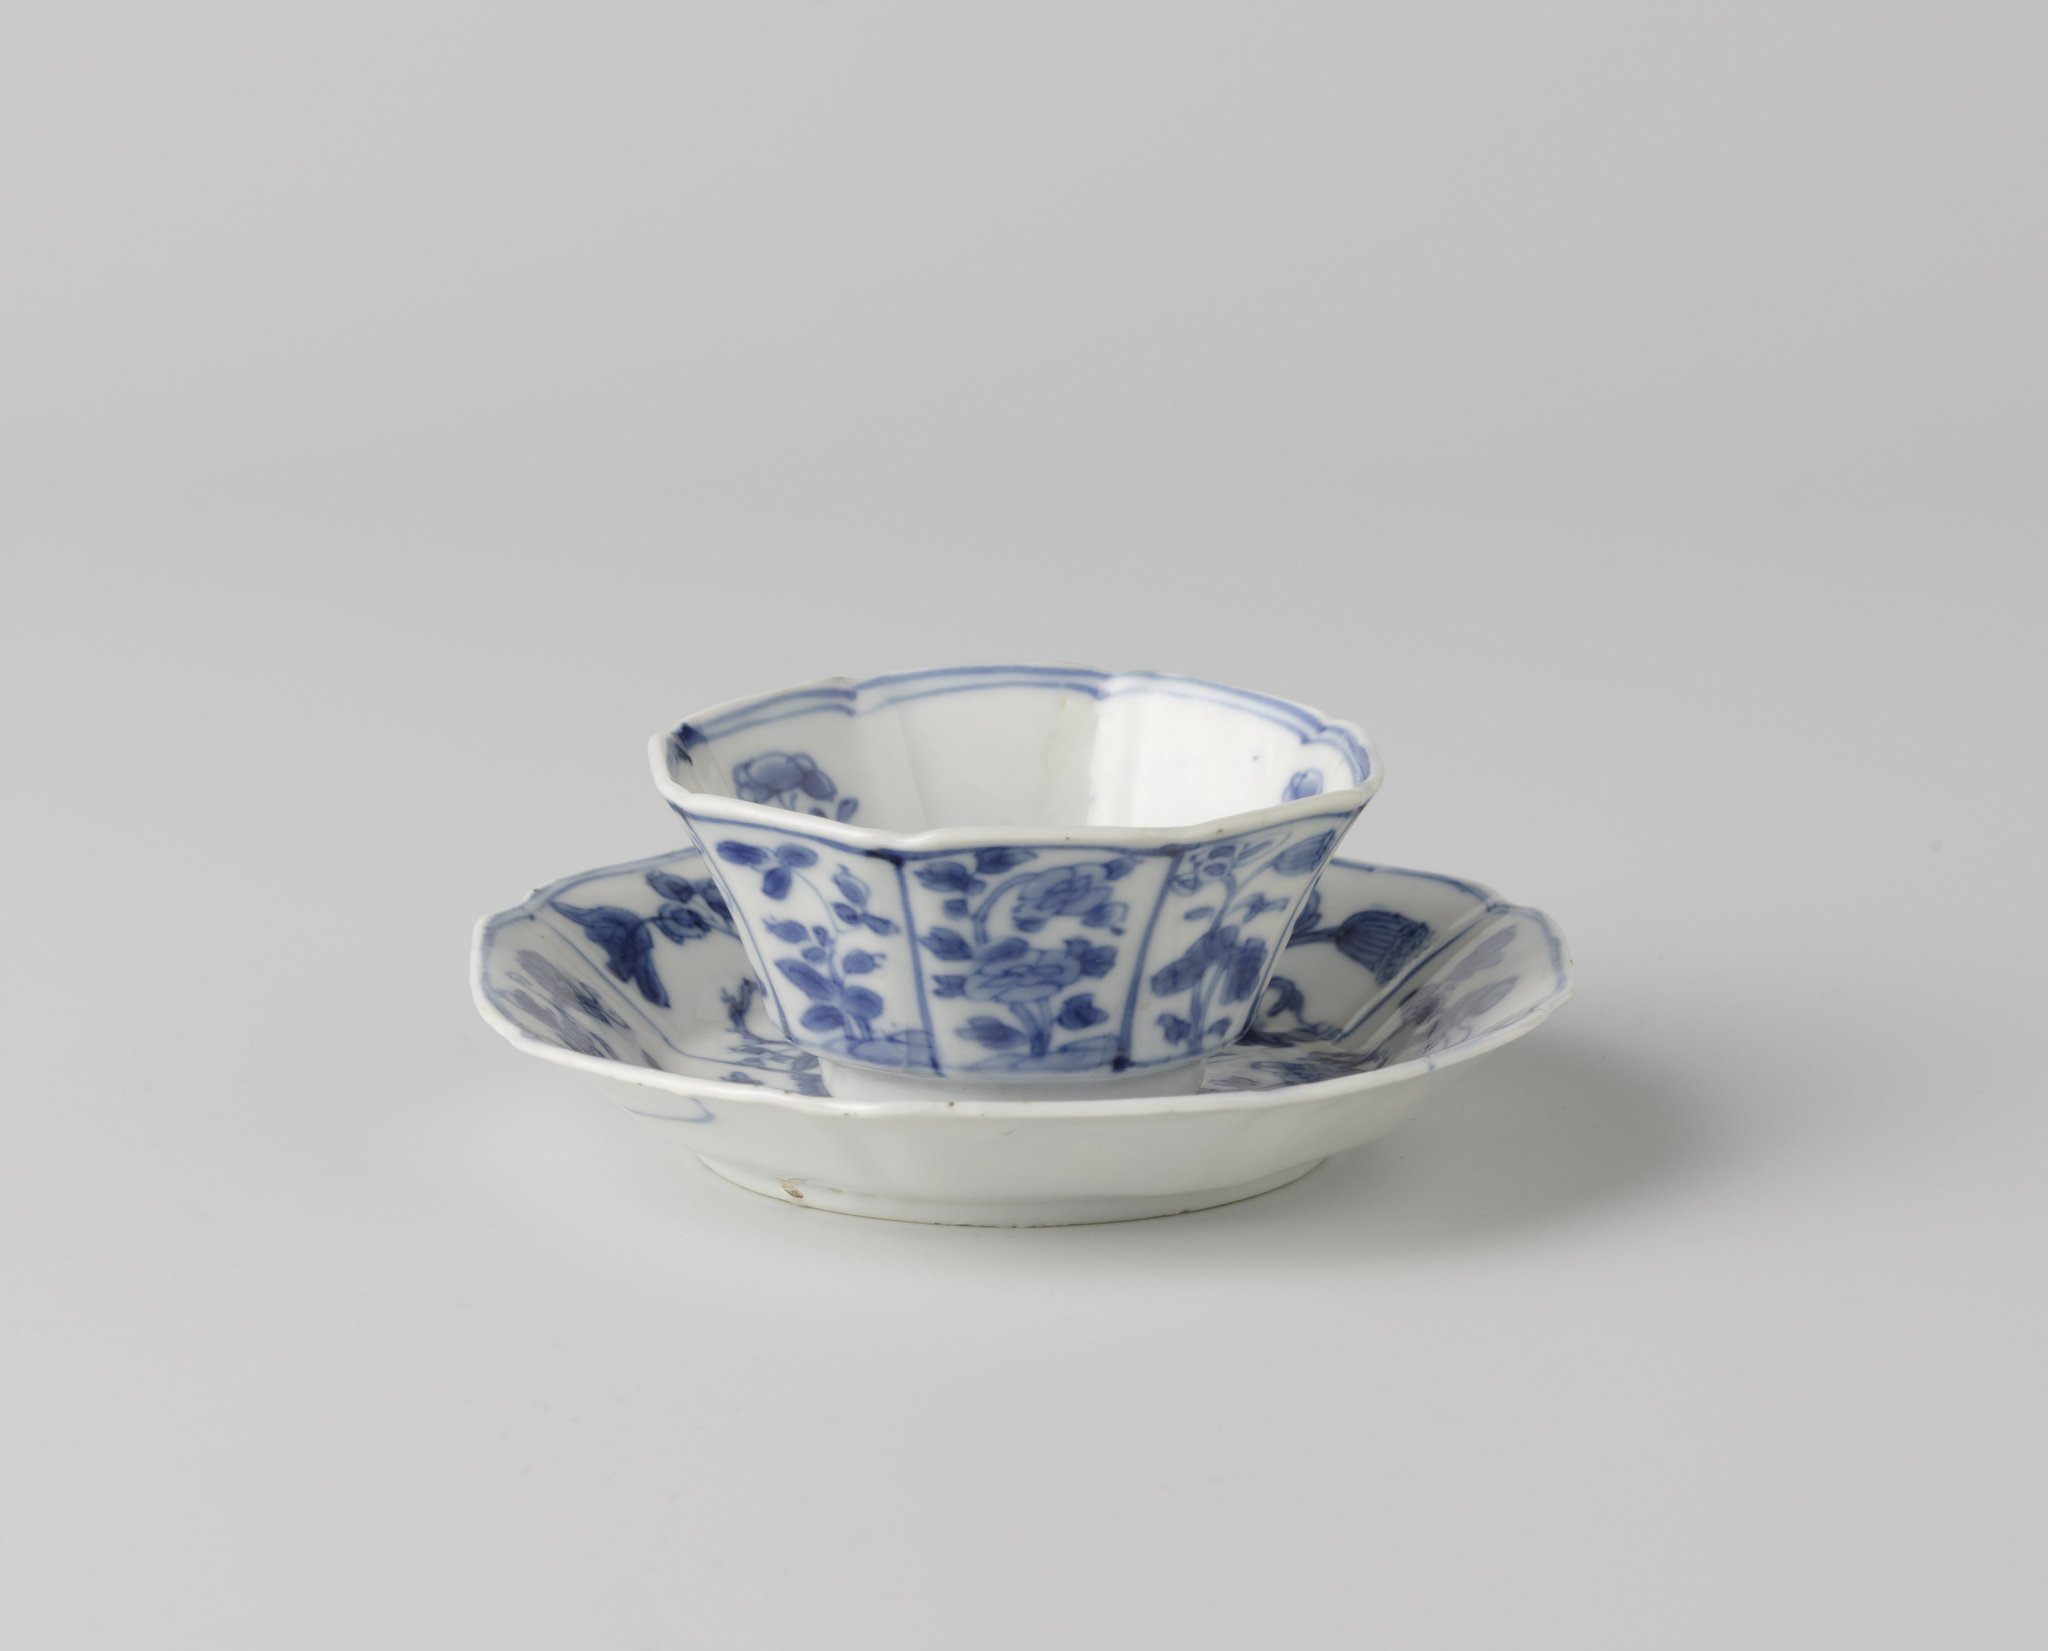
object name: kop en schotel, kop en schotel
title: Octagonal cup and saucer with panel decoration with flower sprays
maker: Anonymous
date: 1680-1720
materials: cobalt, glaze, paint, porcelain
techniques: firing, forming, turning, vitrification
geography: china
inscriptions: mark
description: Achtkantige schotel, gedecoreerd in ondergalzuur blauw. Im het centrum een rozet, acht velden met bloeiende planten daar omheen.